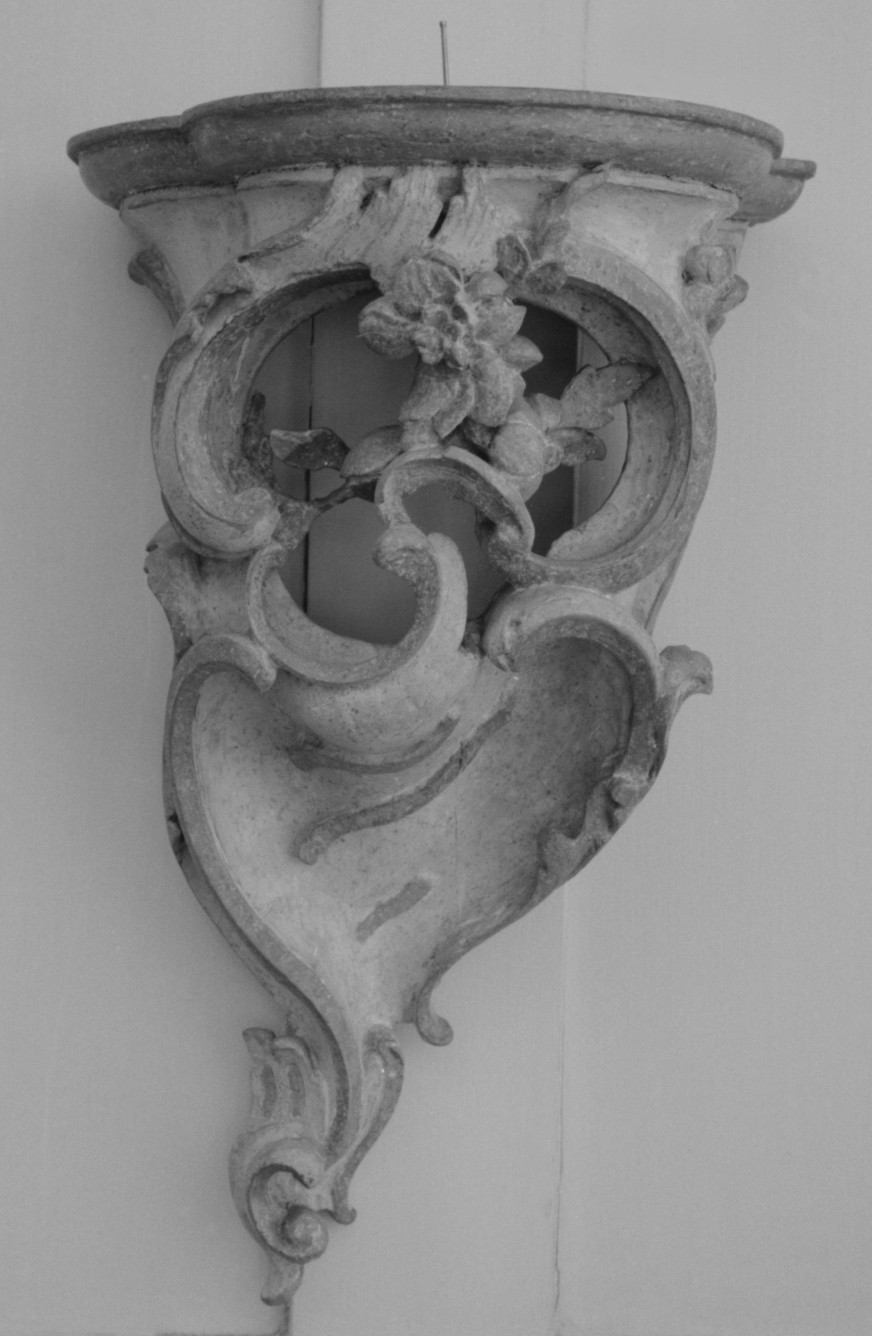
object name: wall bracket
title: Pair of wall brackets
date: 1750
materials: wood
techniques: painting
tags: flowers